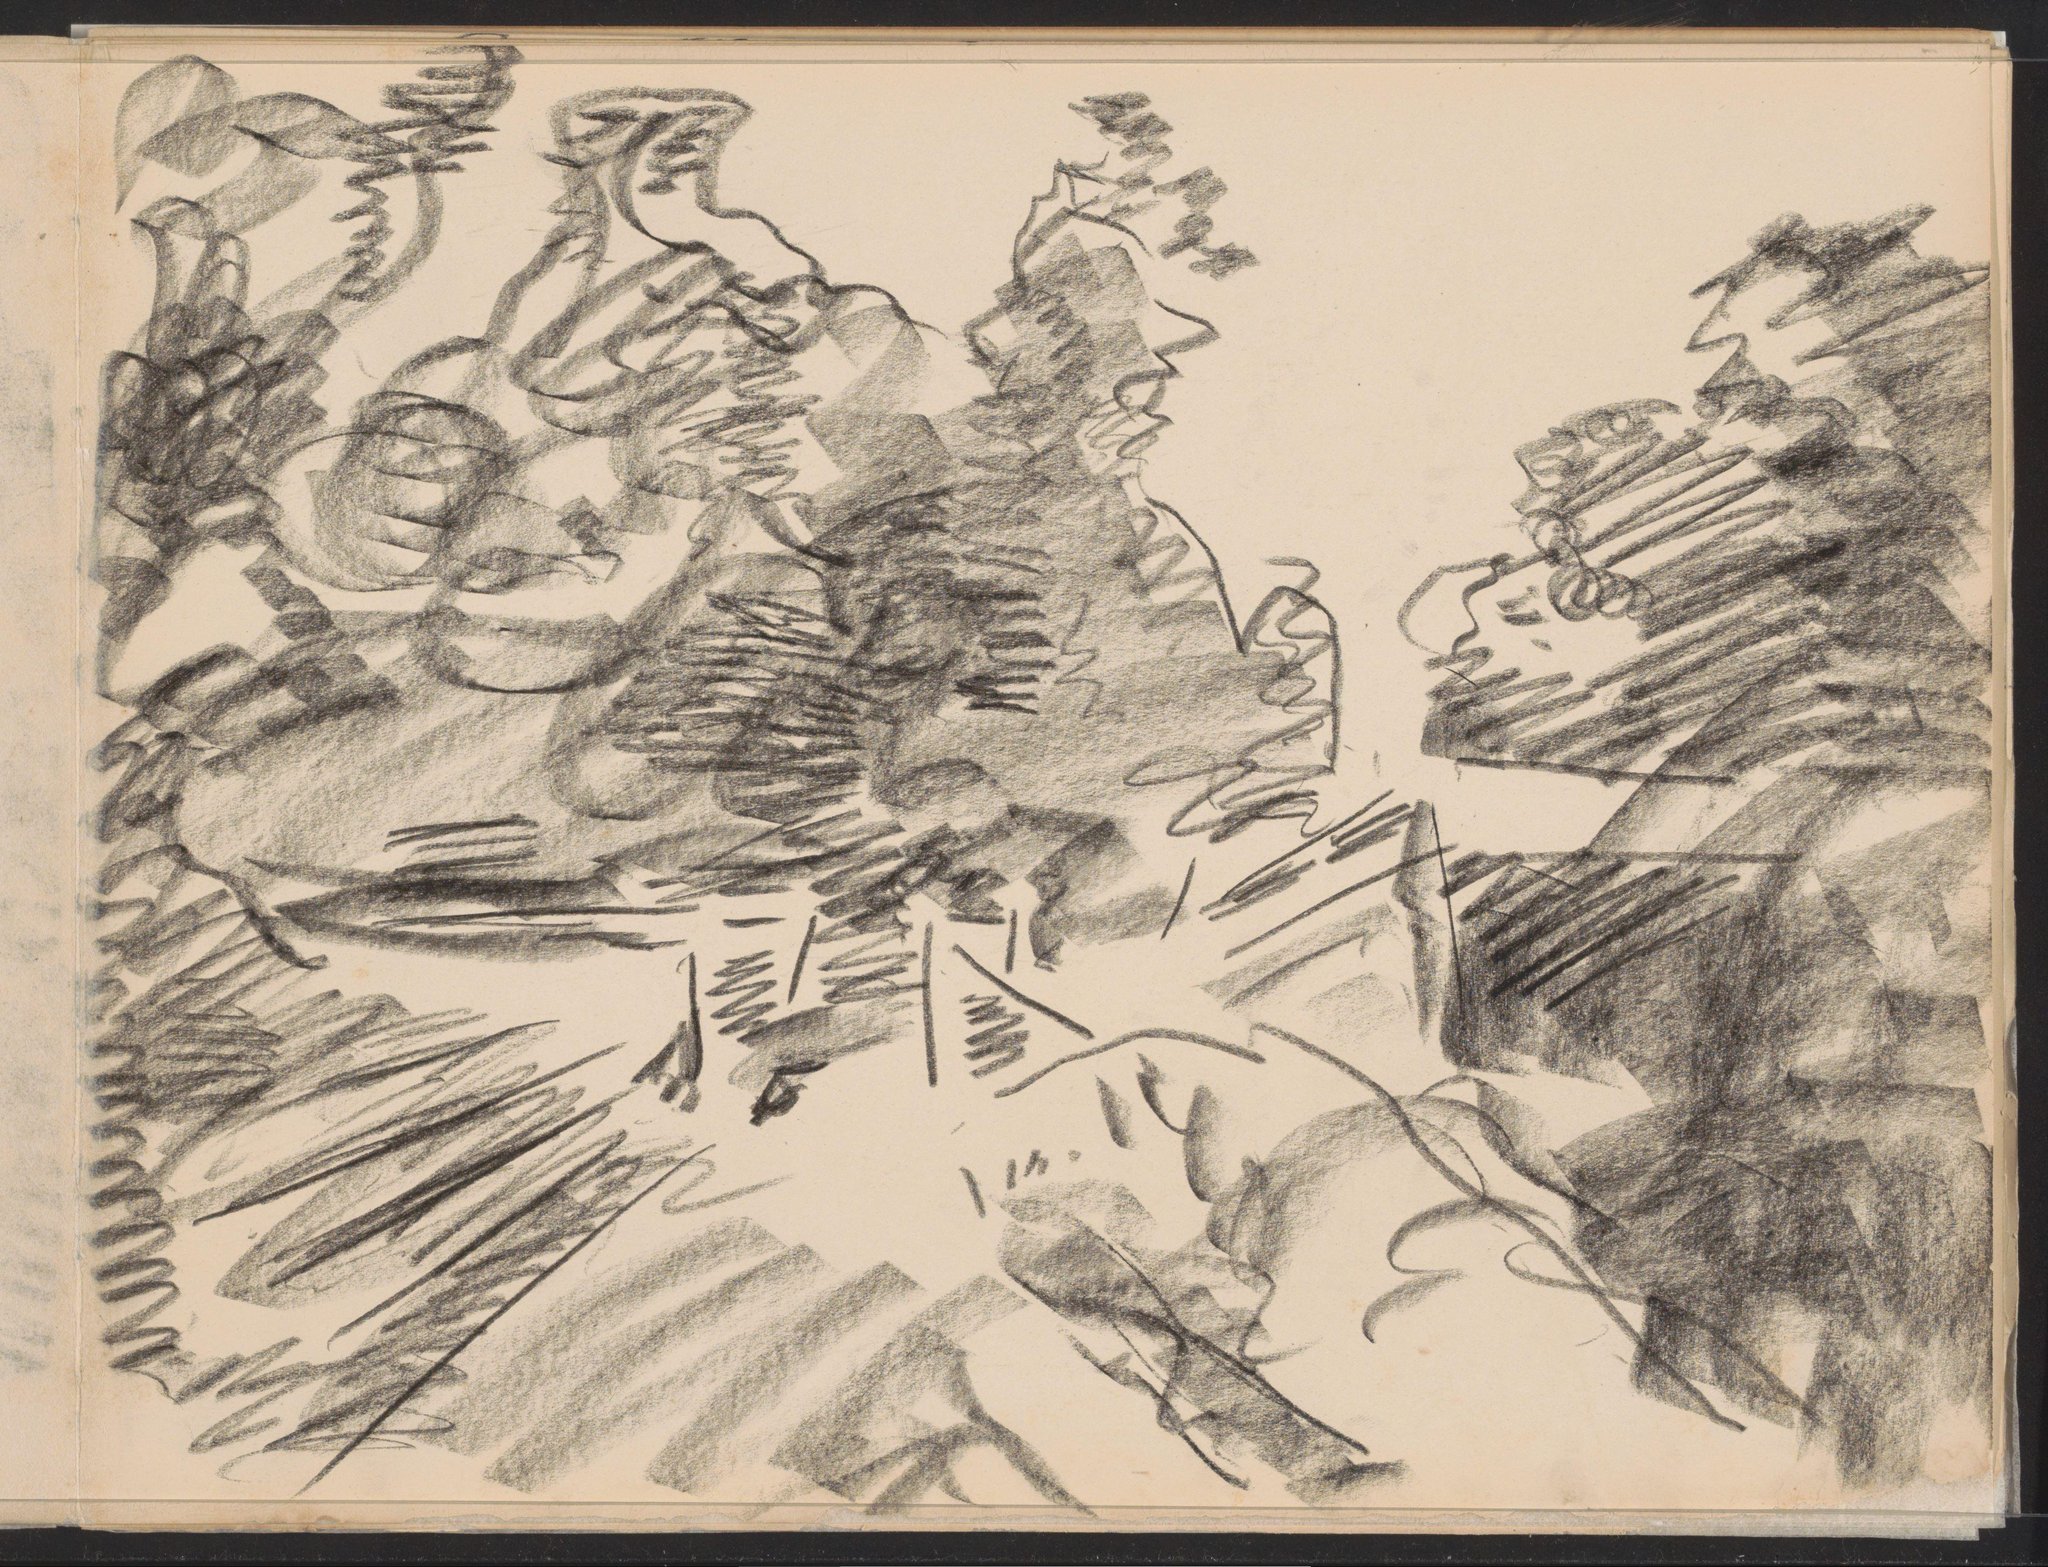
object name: sketchbook leaf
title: Landschap met bomen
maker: willem bastiaan tholen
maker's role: draughtsman, painter, print maker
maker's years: 1860-1931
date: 1870-1931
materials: chalk, paper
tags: trees, landscapes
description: Blad 16 recto uit een schetsboek met 28 bladen.